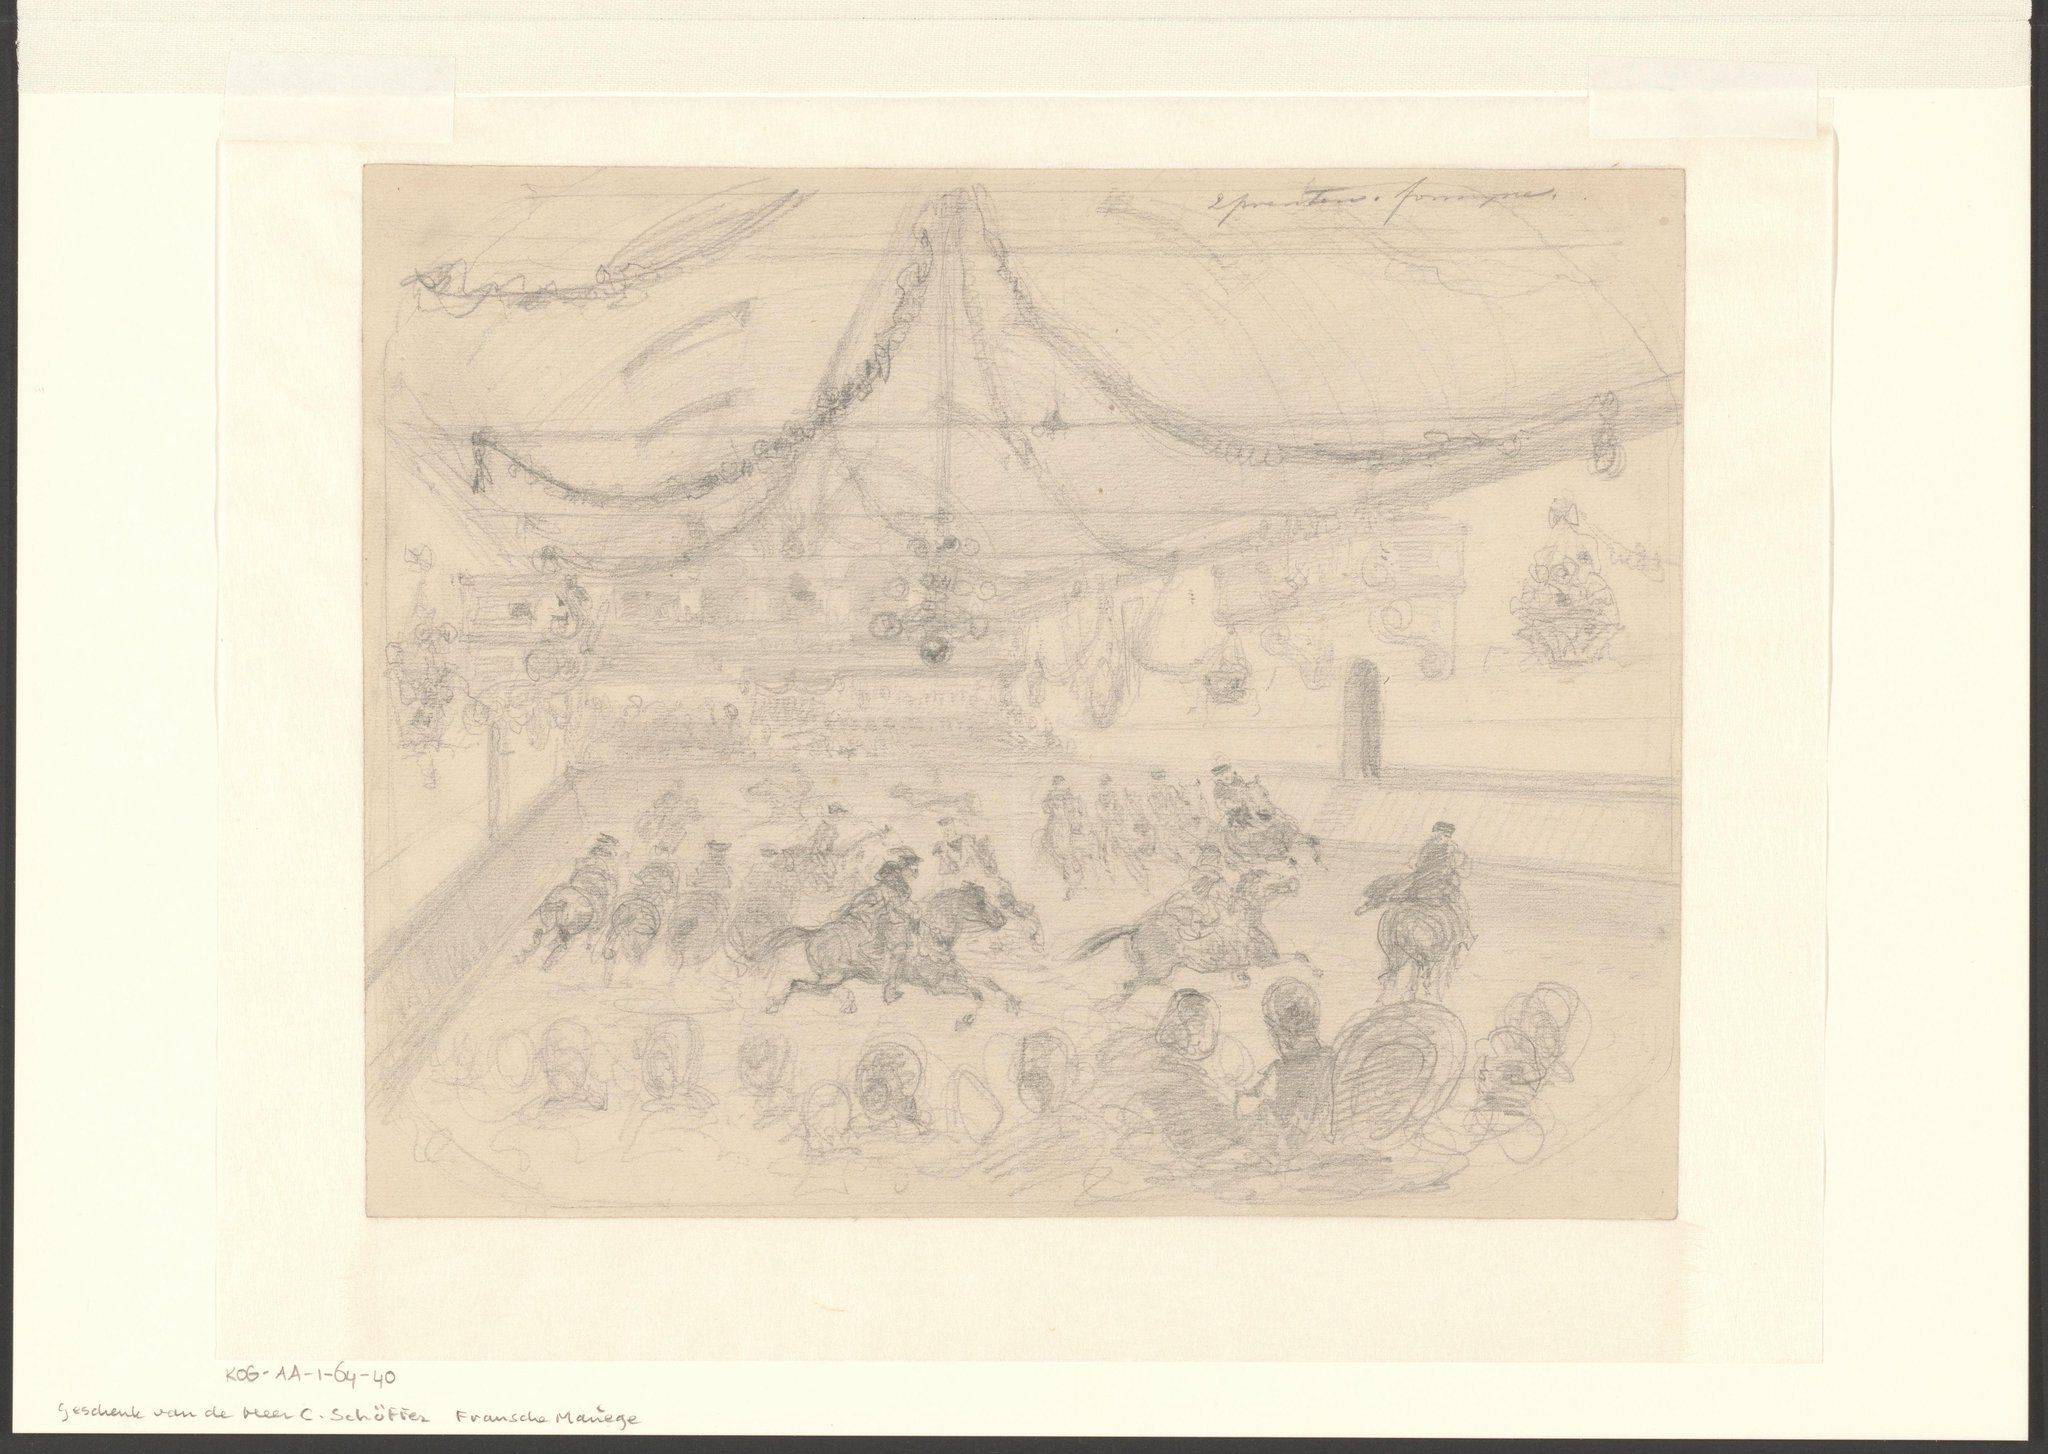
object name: drawing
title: Interieur van de Franse Manege te Amsterdam tijdens ruiterspelen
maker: Anonymous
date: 1853-1888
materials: paper, pencil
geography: amsterdam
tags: riding a horse, ass, or mule; rider, horseman, riding-school, manège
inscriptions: inscription: ‘Geschenk van de Heer C. Schöffer Fransche Manege’, inscription: ‘het blok / niet bij de / warme kachel / Fransche Manege’, inscription: ‘2 prenten fo[...]ne’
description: Onderwerpsrubriek binnen de Atlas Amsterdam: Manegegebouwen.